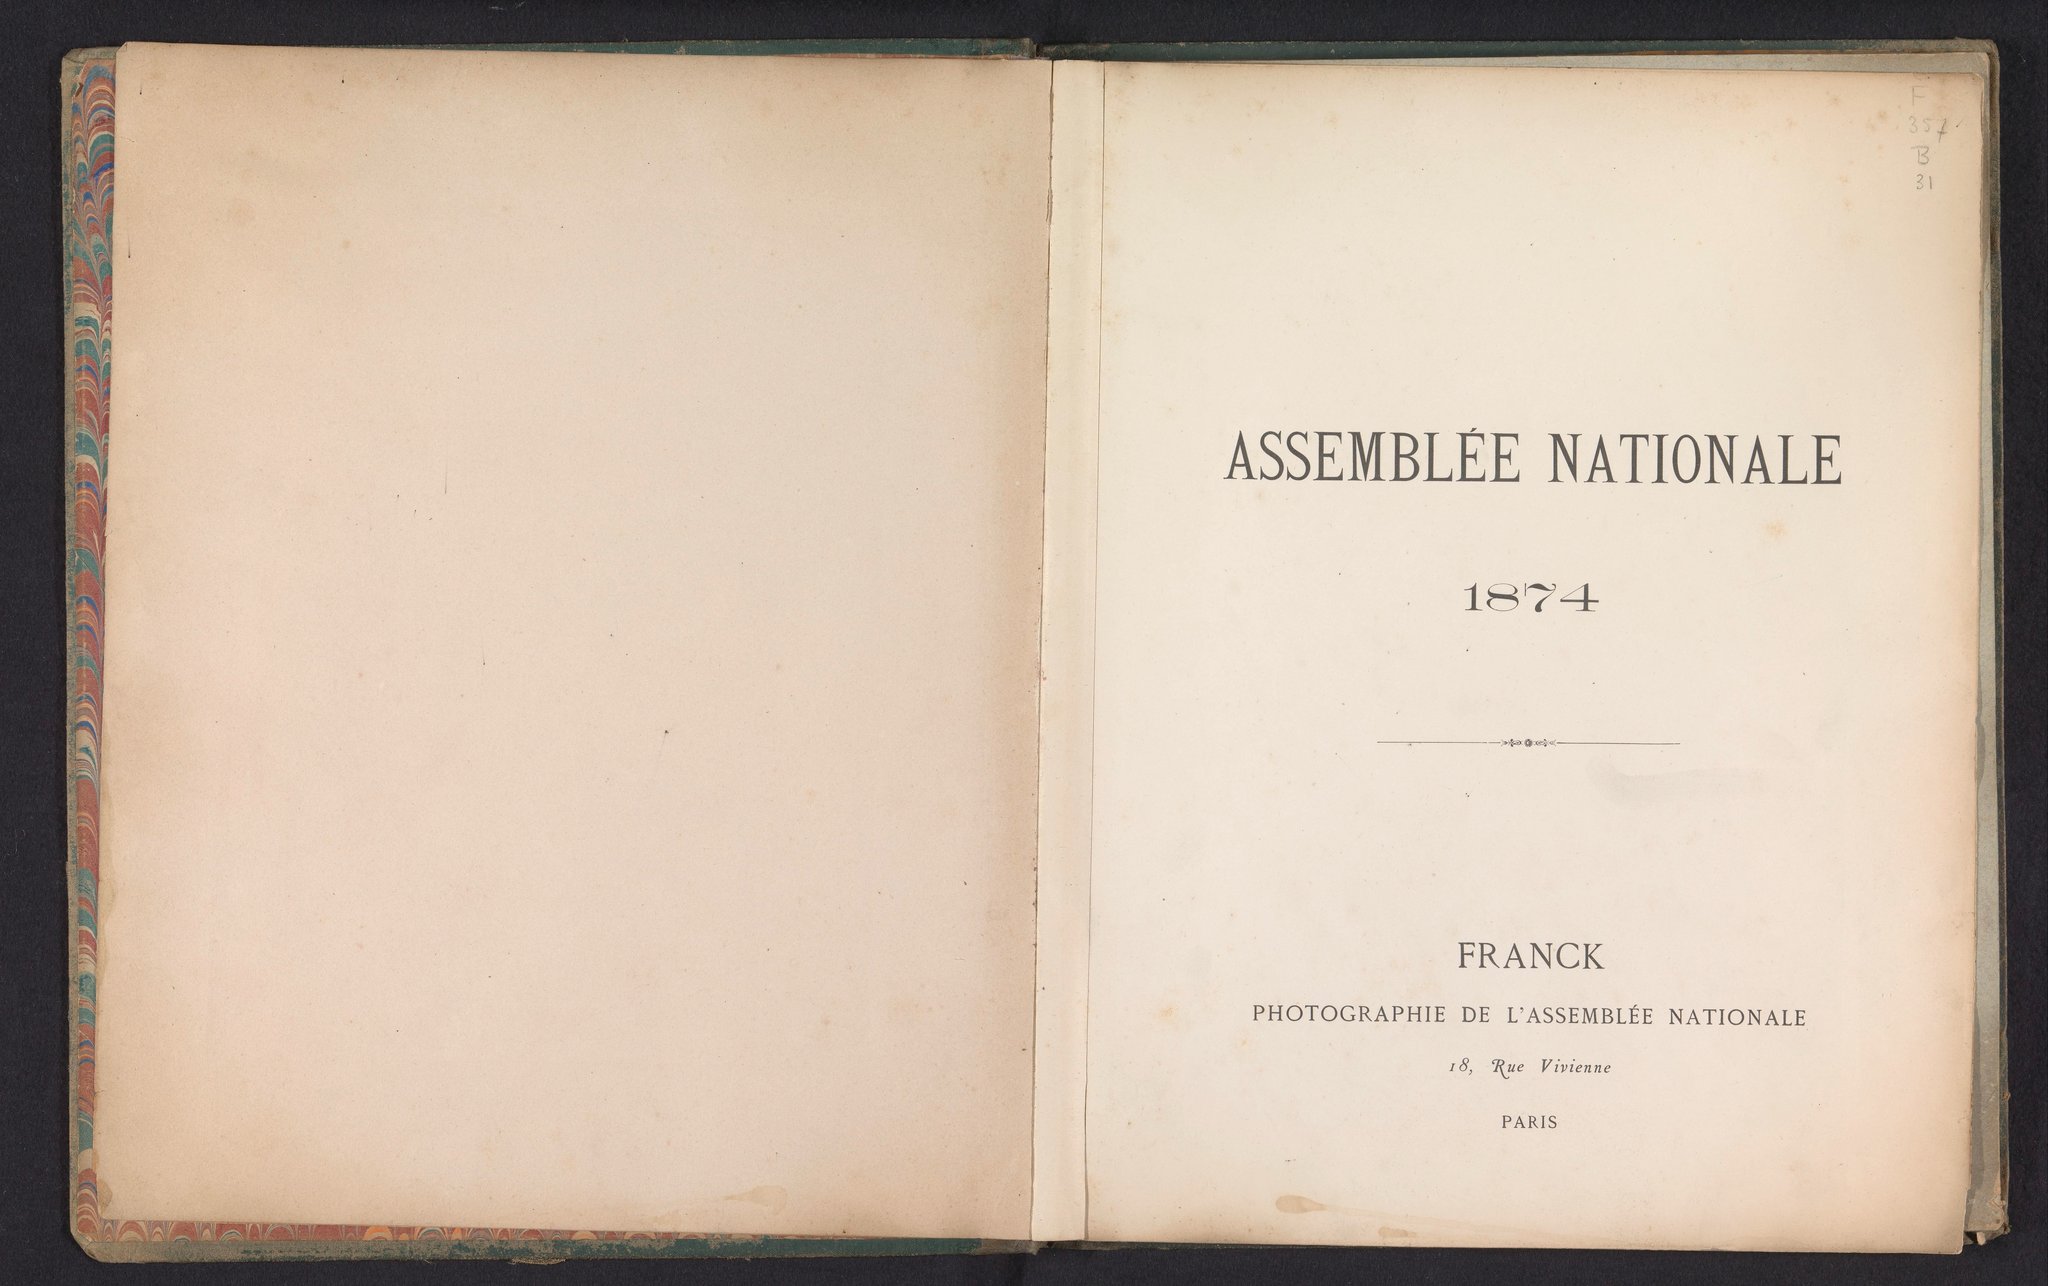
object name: book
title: Assemblée nationale 1874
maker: françois marie louis franck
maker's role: fotograaf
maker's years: 1816-1906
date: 1875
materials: cardboard, paper, photographic support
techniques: albumen print, marbled paper, printing